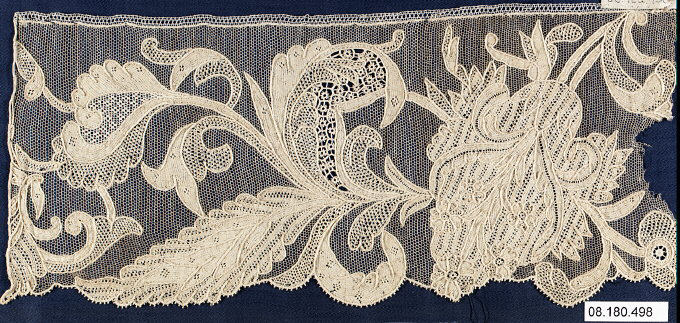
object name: fragment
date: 1801-1900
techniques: lace